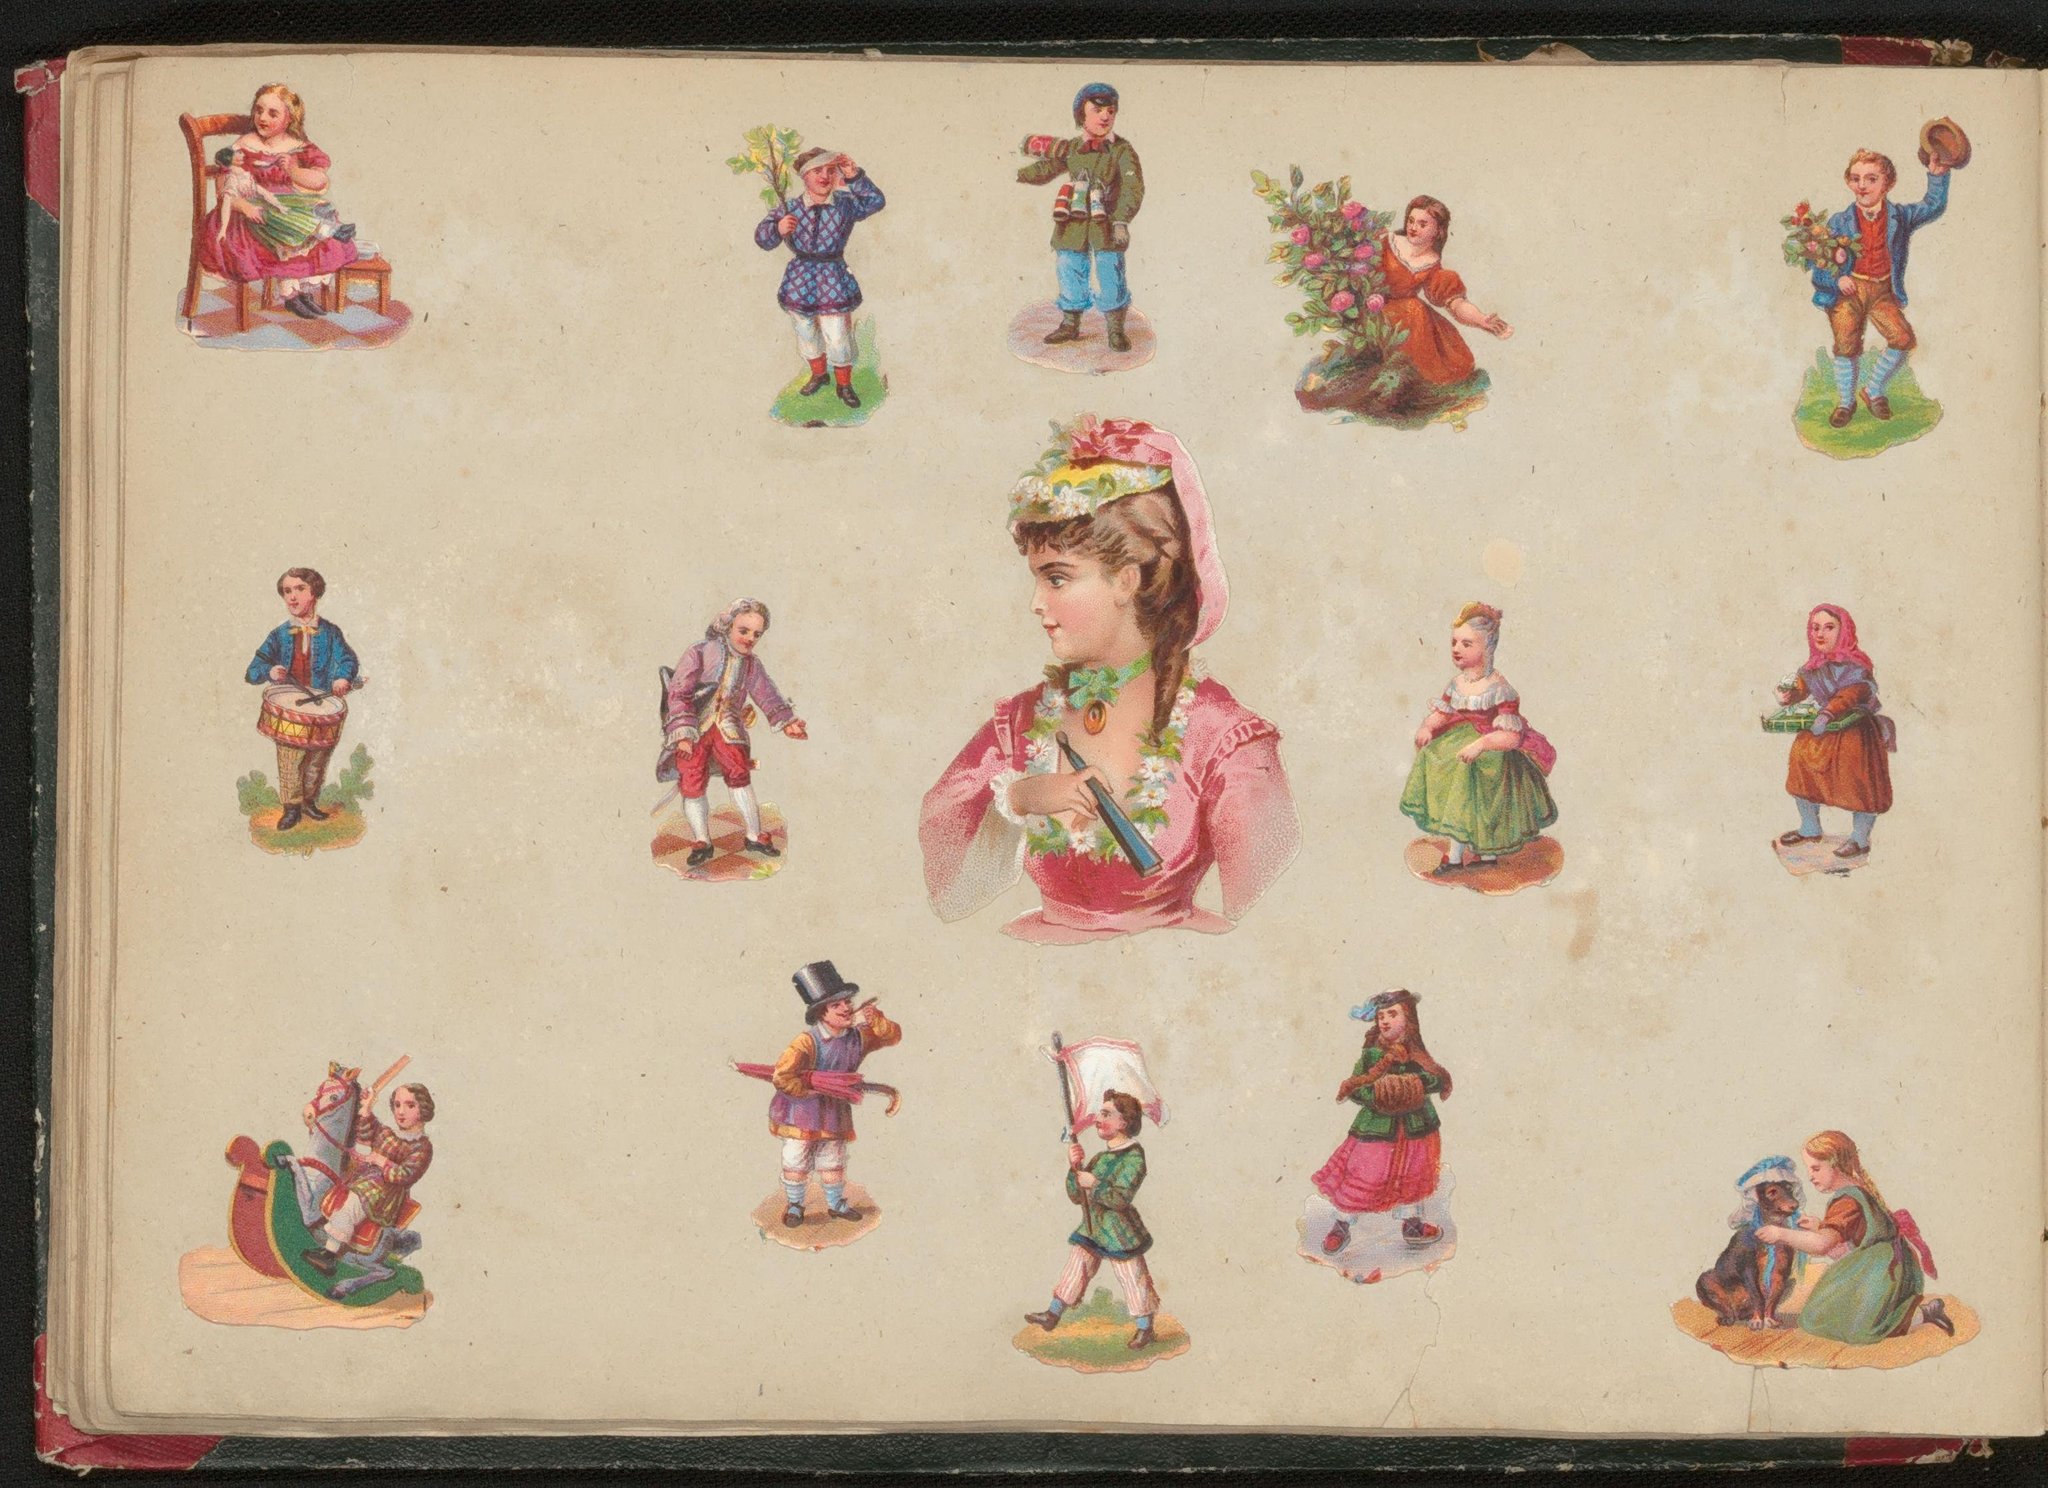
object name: album leaf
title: Albumblad met 15 plakplaatjes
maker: Anonymous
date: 1880-1910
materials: paper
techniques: chromolithography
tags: children's games and plays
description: Albumblad met 15 plakplaatjes van spelende kinderen, centraal een elegante jonge vrouw. Onderdeel van het plakboek met 38 bladen gevuld met plakplaatjes, poesieplaatjes en uitgeknipte en ingeplakte fragmenten van prenten. Onderwerpsrubrieken binnen de Atlas Zeden en Gewoonten: Schoone kunsten, Varia.